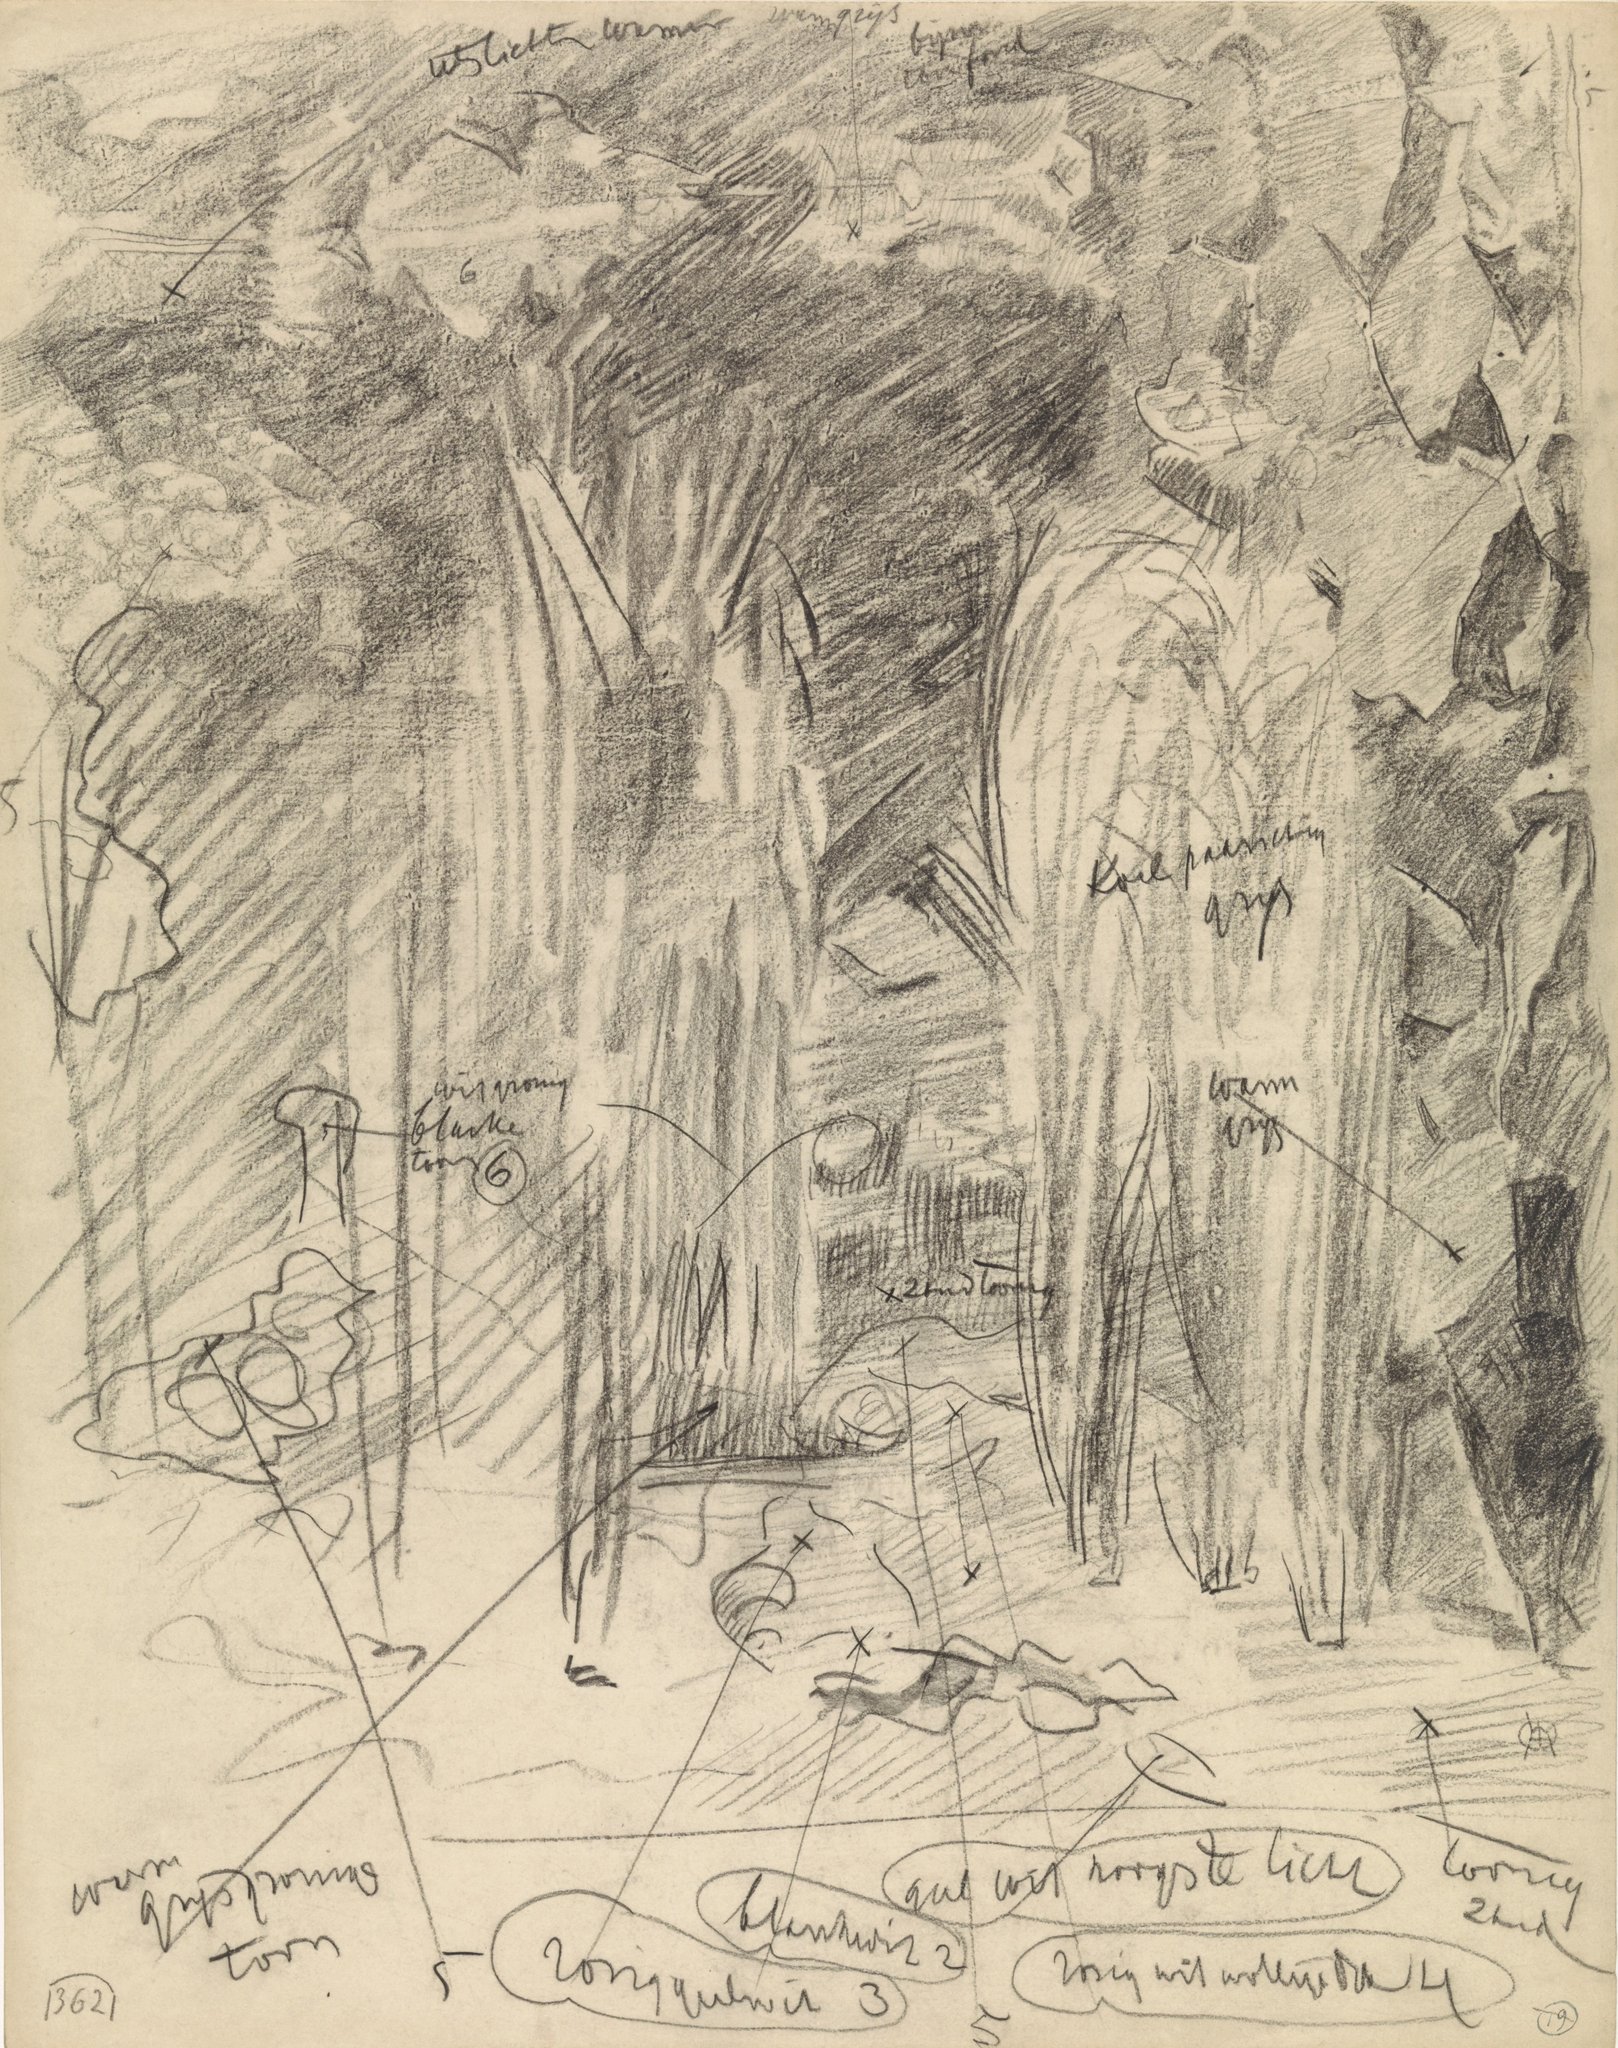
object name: drawing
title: Aquarium met waterplanten en kleurnotities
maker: gerrit willem dijsselhof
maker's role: designer, draughtsman, print maker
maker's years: 1866-1924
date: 1876-1924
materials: chalk, paper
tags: aquarium, plants and herbs